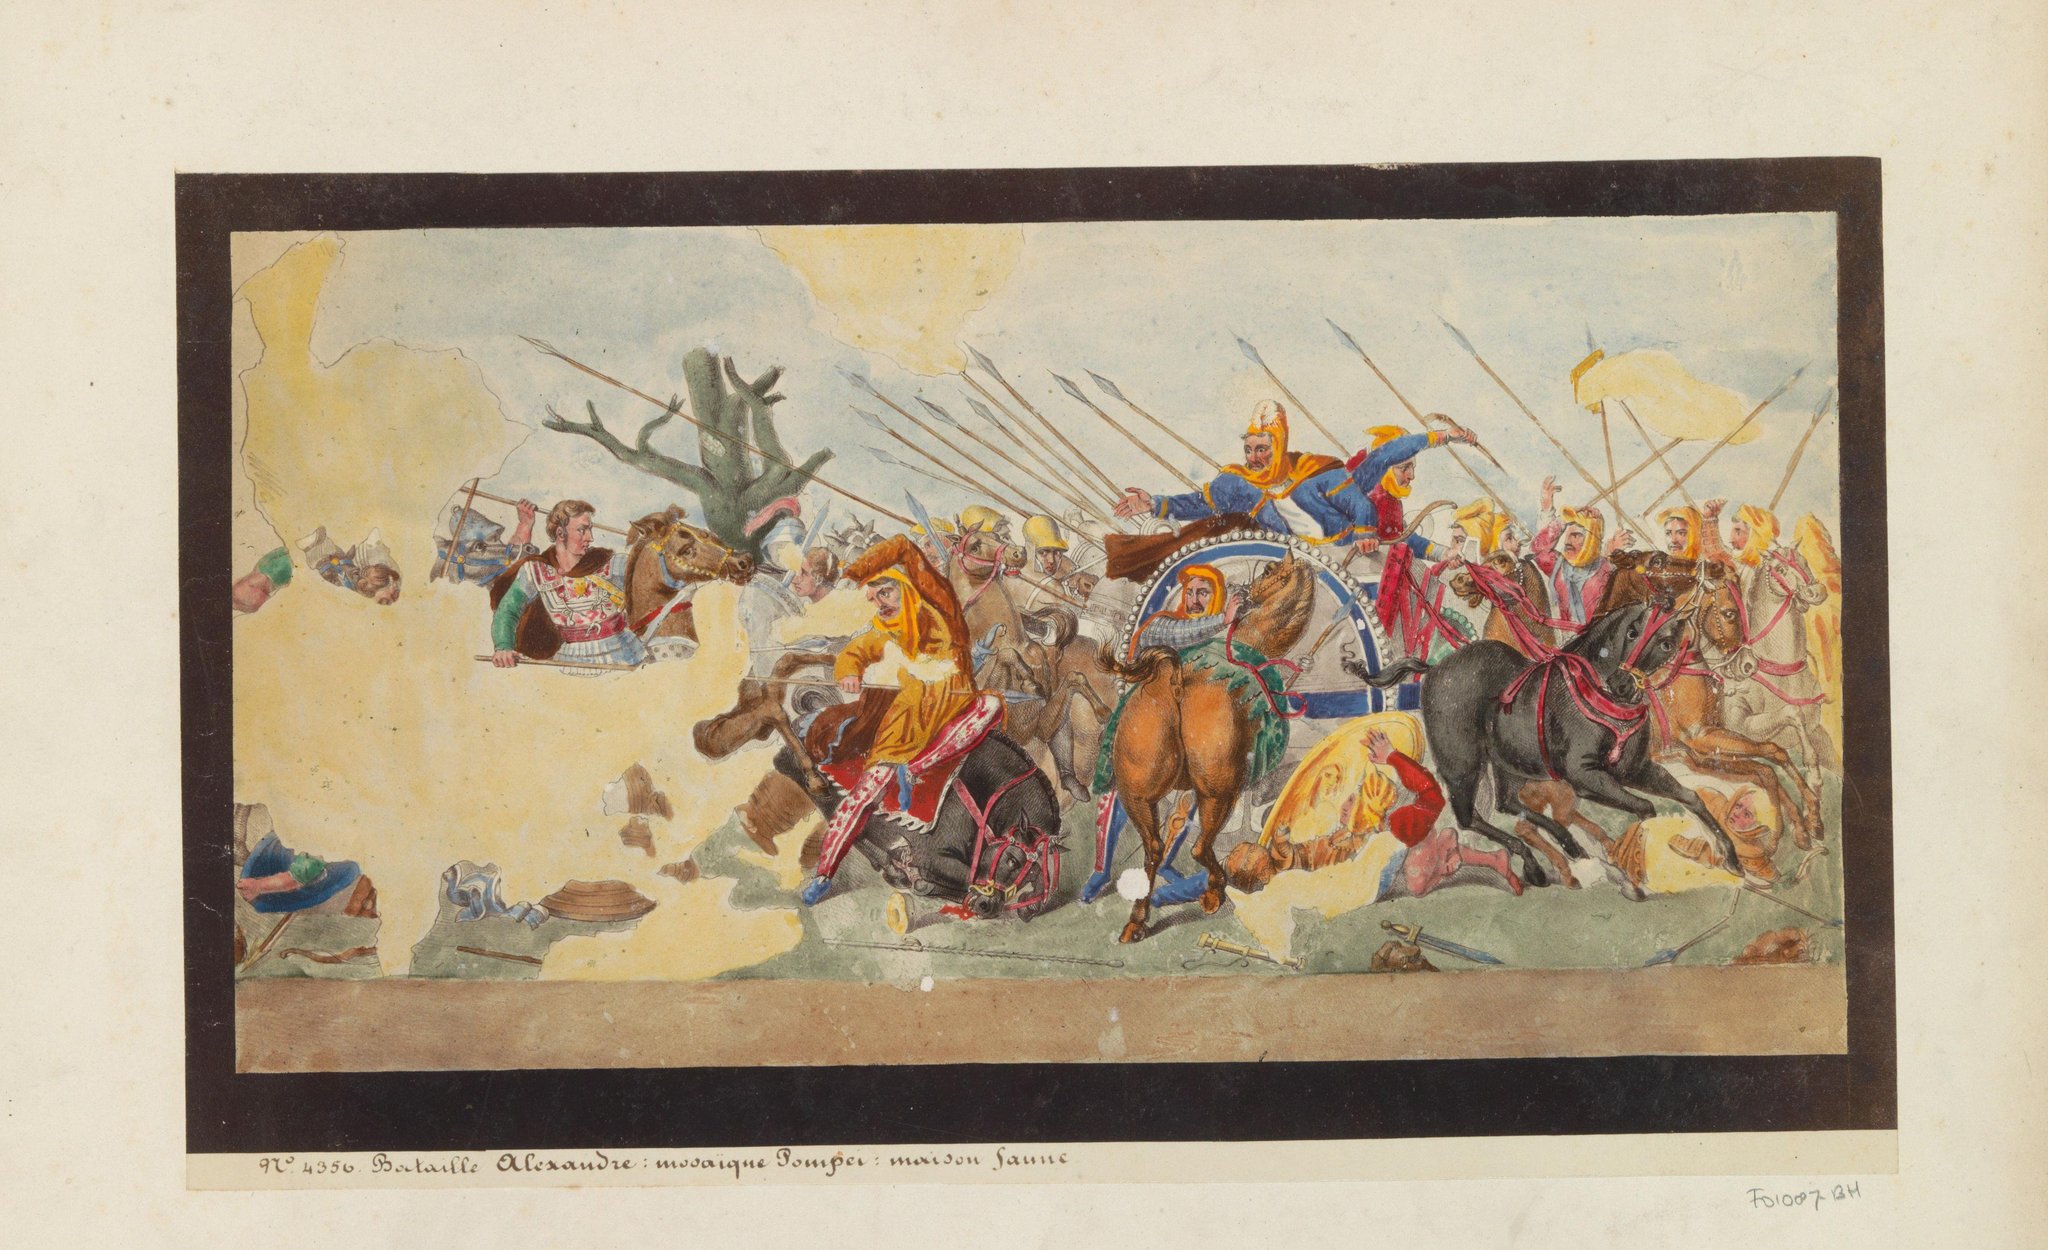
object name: photograph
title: Alexandermozaïek in het Huis van de Faun in Pompeï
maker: Anonymous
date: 1865-1875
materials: paper, photographic support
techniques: albumen print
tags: battle, fighting in general (+ irregular troops), pompeii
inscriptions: negative number: ‘4356’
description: Onderdeel van Reisalbum met foto's van bezienswaardigheden in Napels en omgeving.